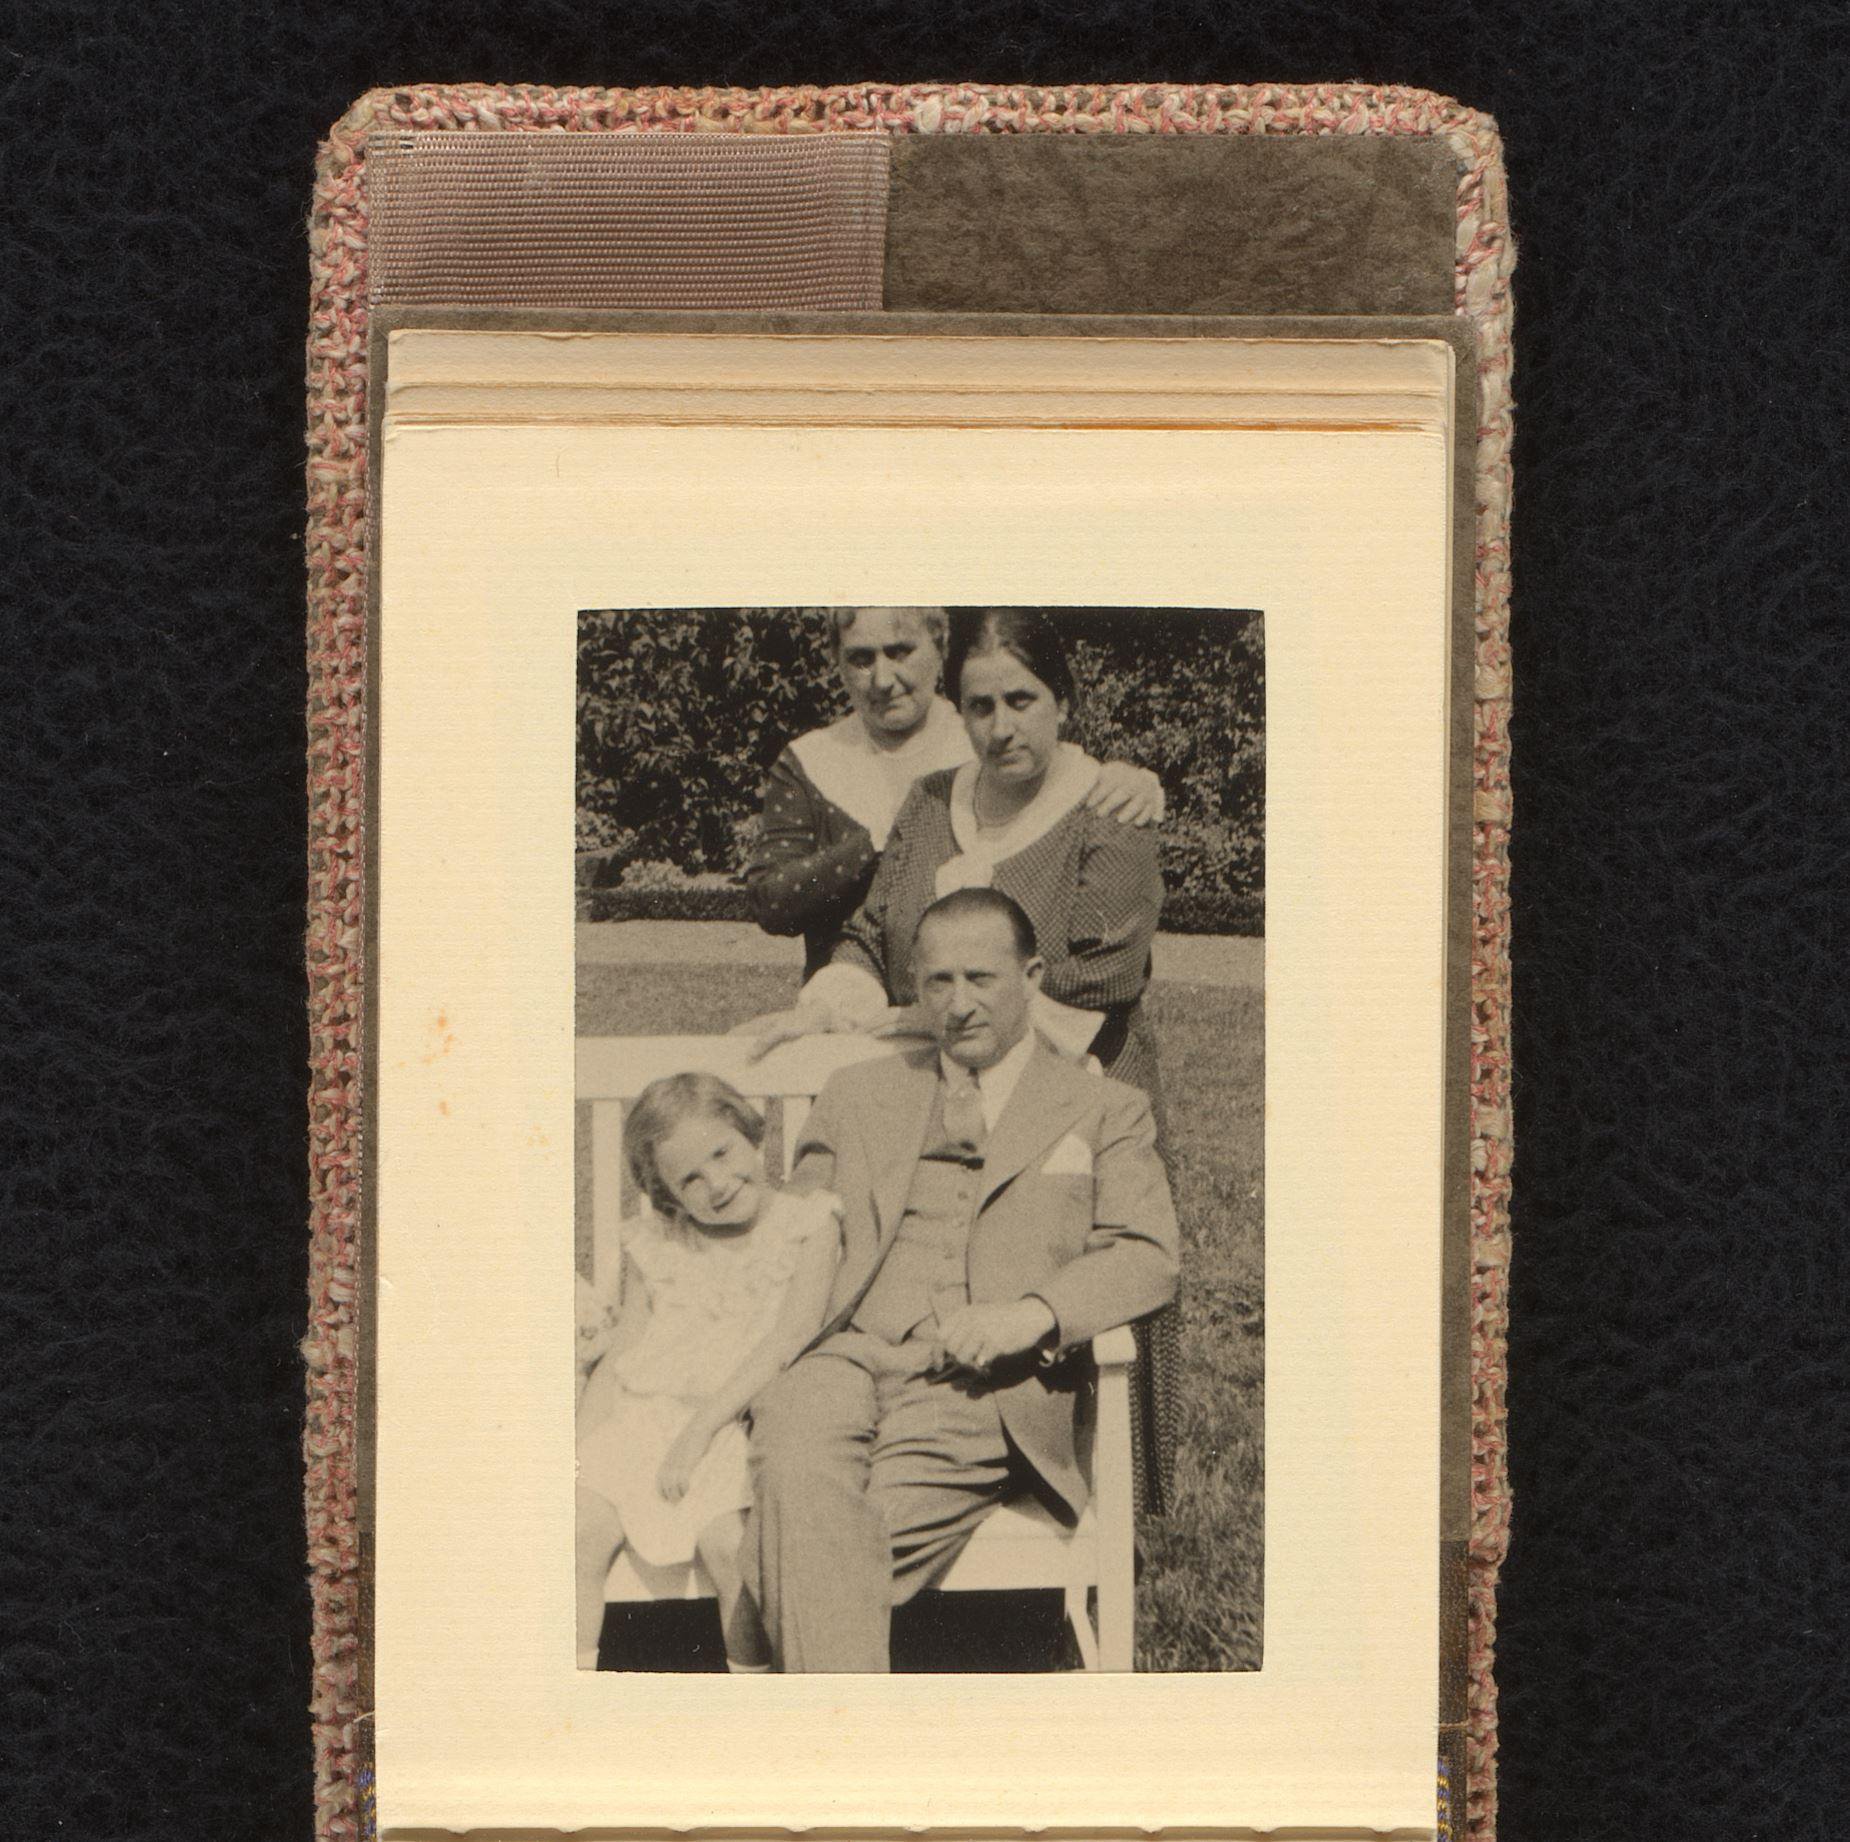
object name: album leaf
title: Isabel Wachenheimer op de bank met haar oom Willy Moos, en haar moeder Else Wachenheimer-Moos en een onbekende vrouw op de achtergrond, juli-augustus 1933, Hamburg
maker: else wachenheimer-moos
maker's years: 1895-1944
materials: paper, photographic support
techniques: gelatin silver print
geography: hamburg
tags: else wachenheimer-moos, isabel wachenheimer-elon, willy moos, the family travelling, on holiday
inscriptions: date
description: Albumblad bevat een foto van Isabel Wachenheimer (links voor), Willy Moos (rechts voor), Else Wachenheimer-Moos (rechts achter) en onbekende vrouw (links achter). Onderdeel van het fotoalbum Hamburg zomer 1933.